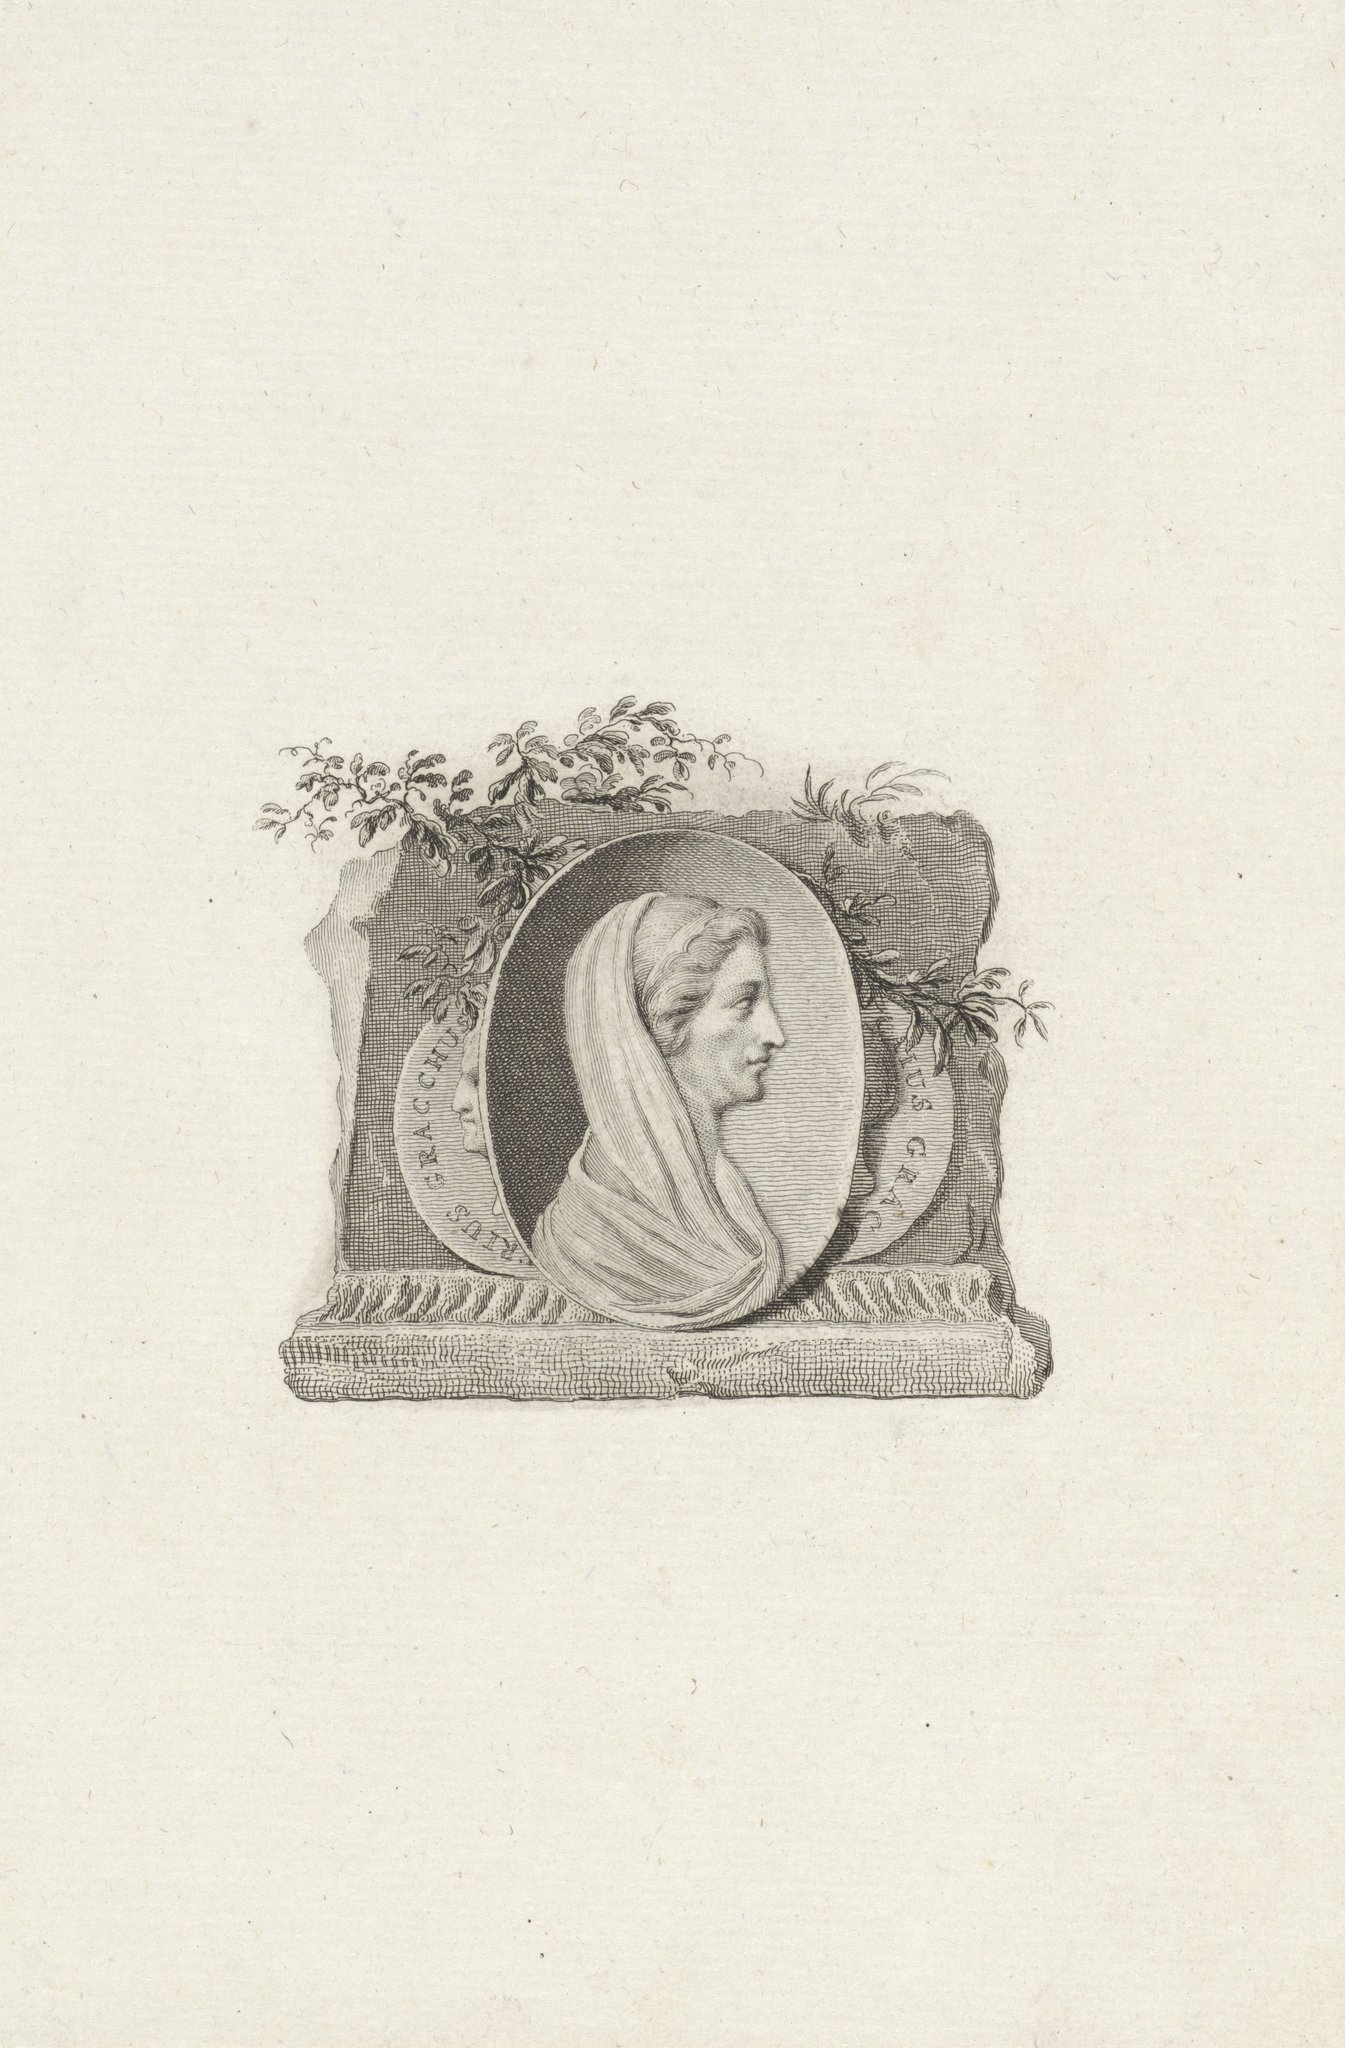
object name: book illustration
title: Medaillon met het portret van Cornelia, moeder der Gracchen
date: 1798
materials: paper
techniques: etching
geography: amsterdam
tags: (story of) gaius sempronius gracchus, (story of) tiberius sempronius gracchus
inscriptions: collector's mark: Lugt 240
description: Steen met een medaillon. Daarop het portret van Cornelia, moeder der Gracchen. De portretten van de broers Gaius en Tiberius Gracchus zijn deels achter het portret van de vrouw zichtbaar.